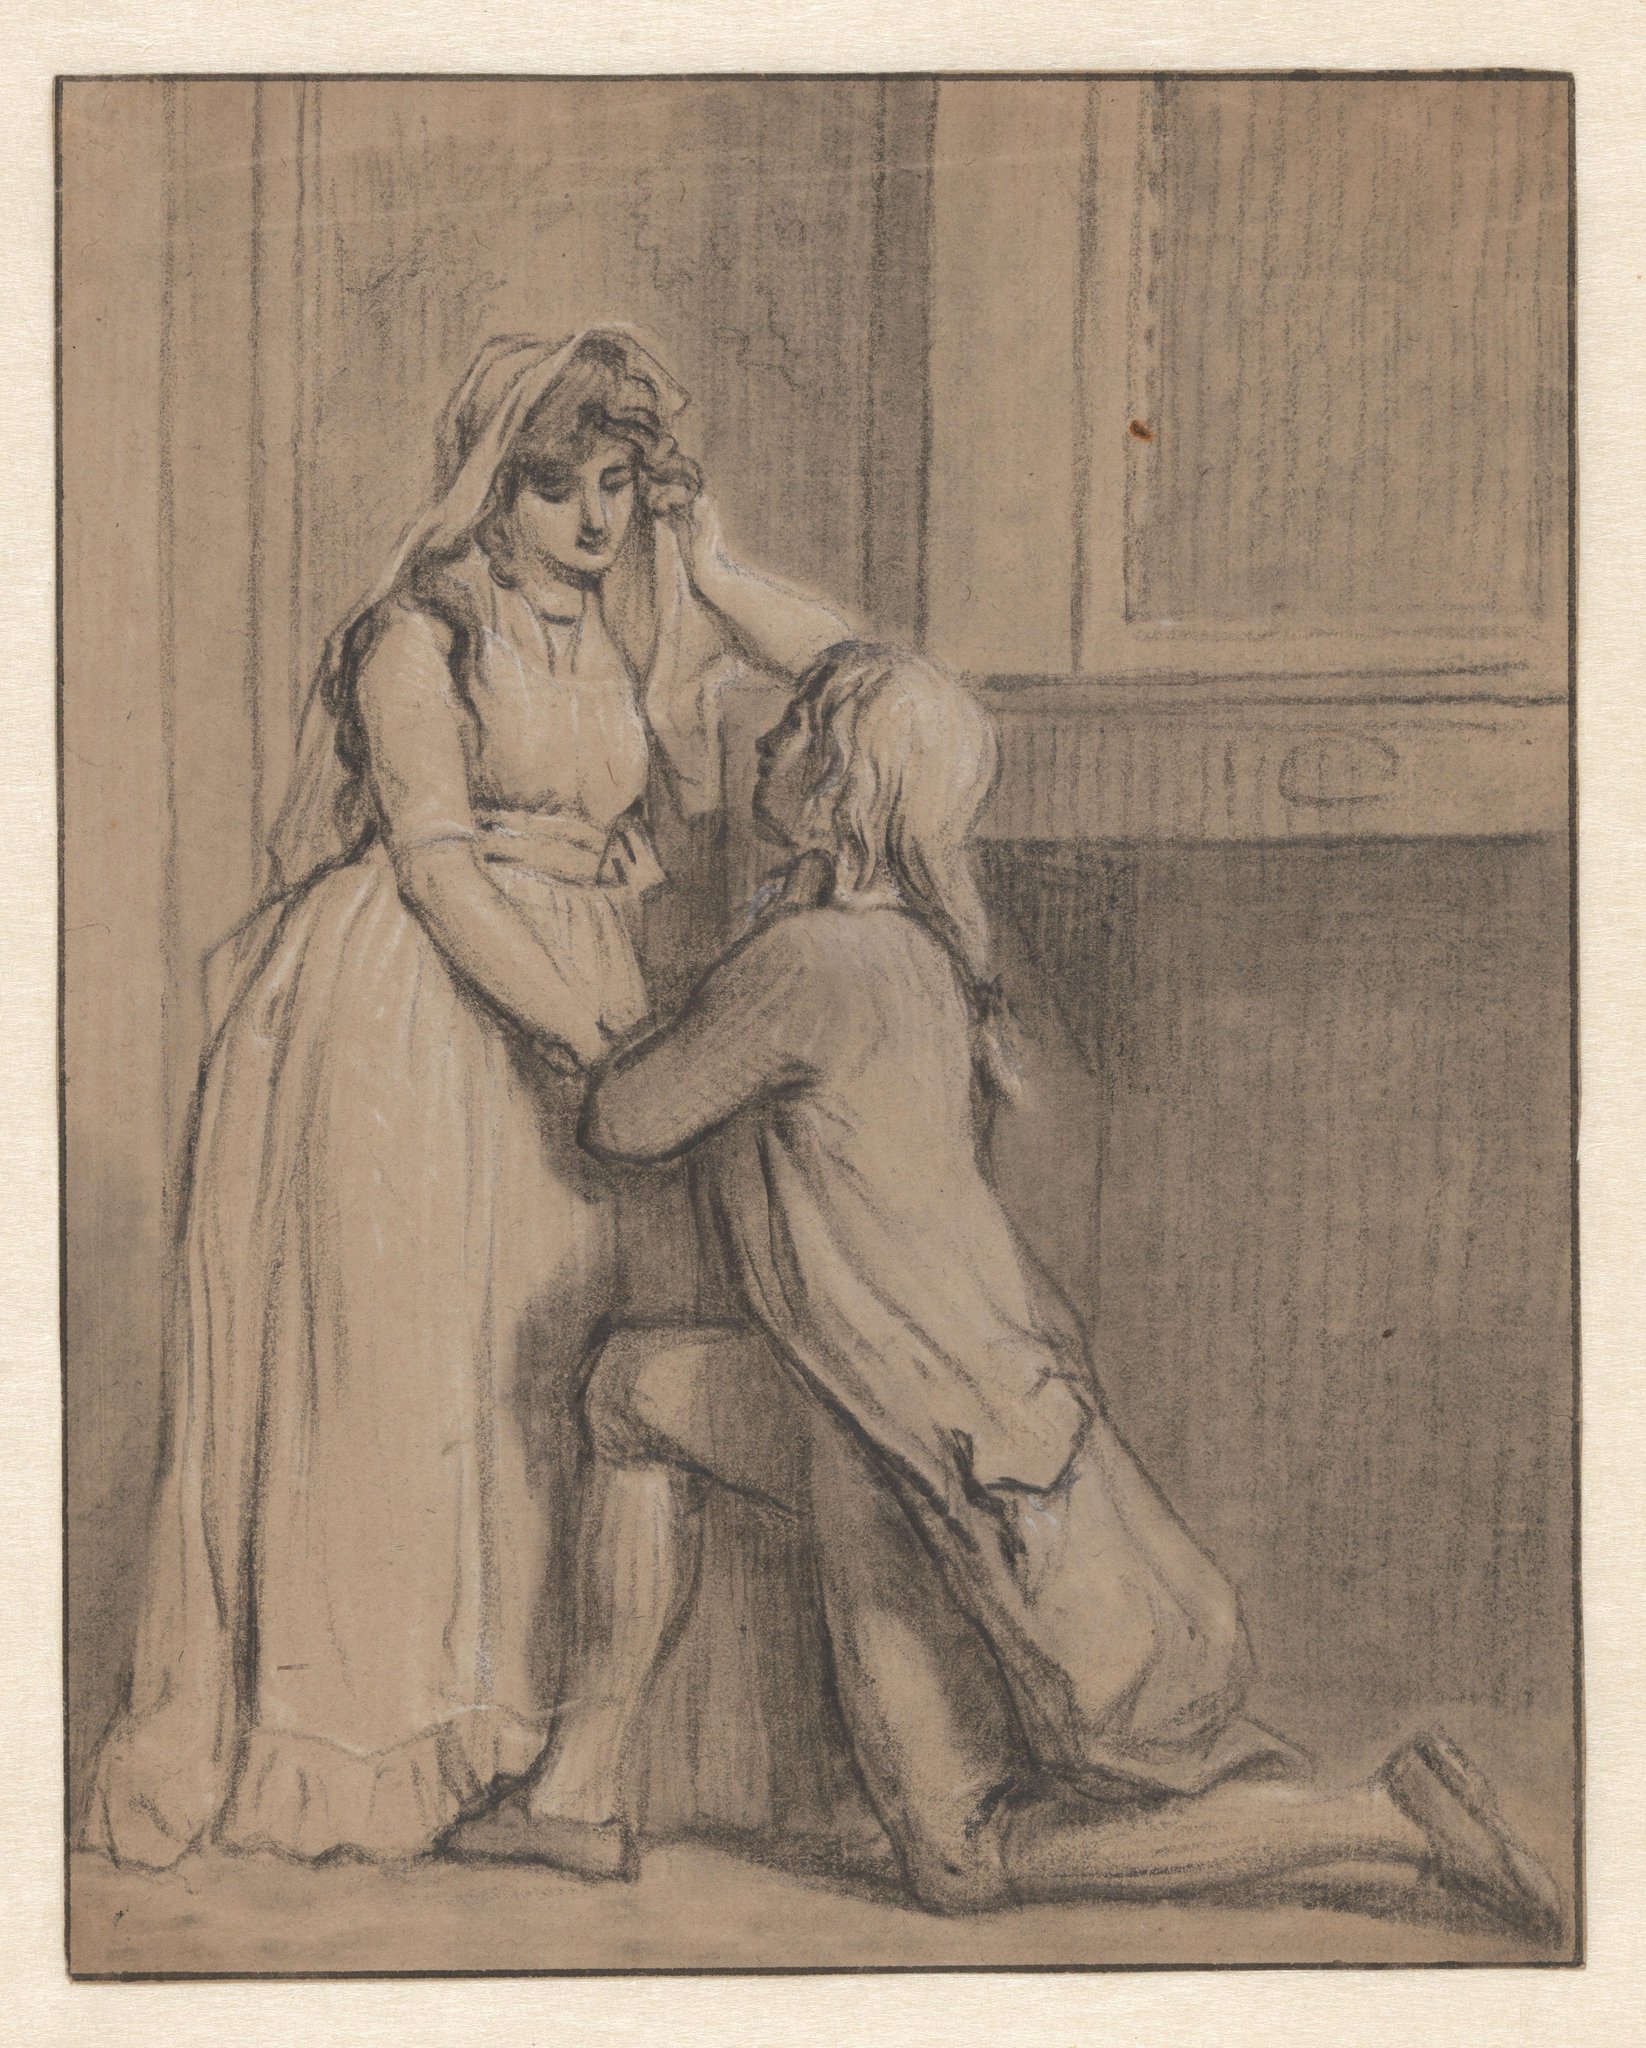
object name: drawing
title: The proposal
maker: jurriaan andriessen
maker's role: draughtsman, painter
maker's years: 1742-1819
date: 1800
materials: chalk, ink, paper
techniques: brush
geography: amsterdam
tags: man kneeling before his beloved (proposing)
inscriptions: inscription: ‘J. Andriessen del.’, inscription: ‘9 25/12 5’, collector's mark: Lugt 4618